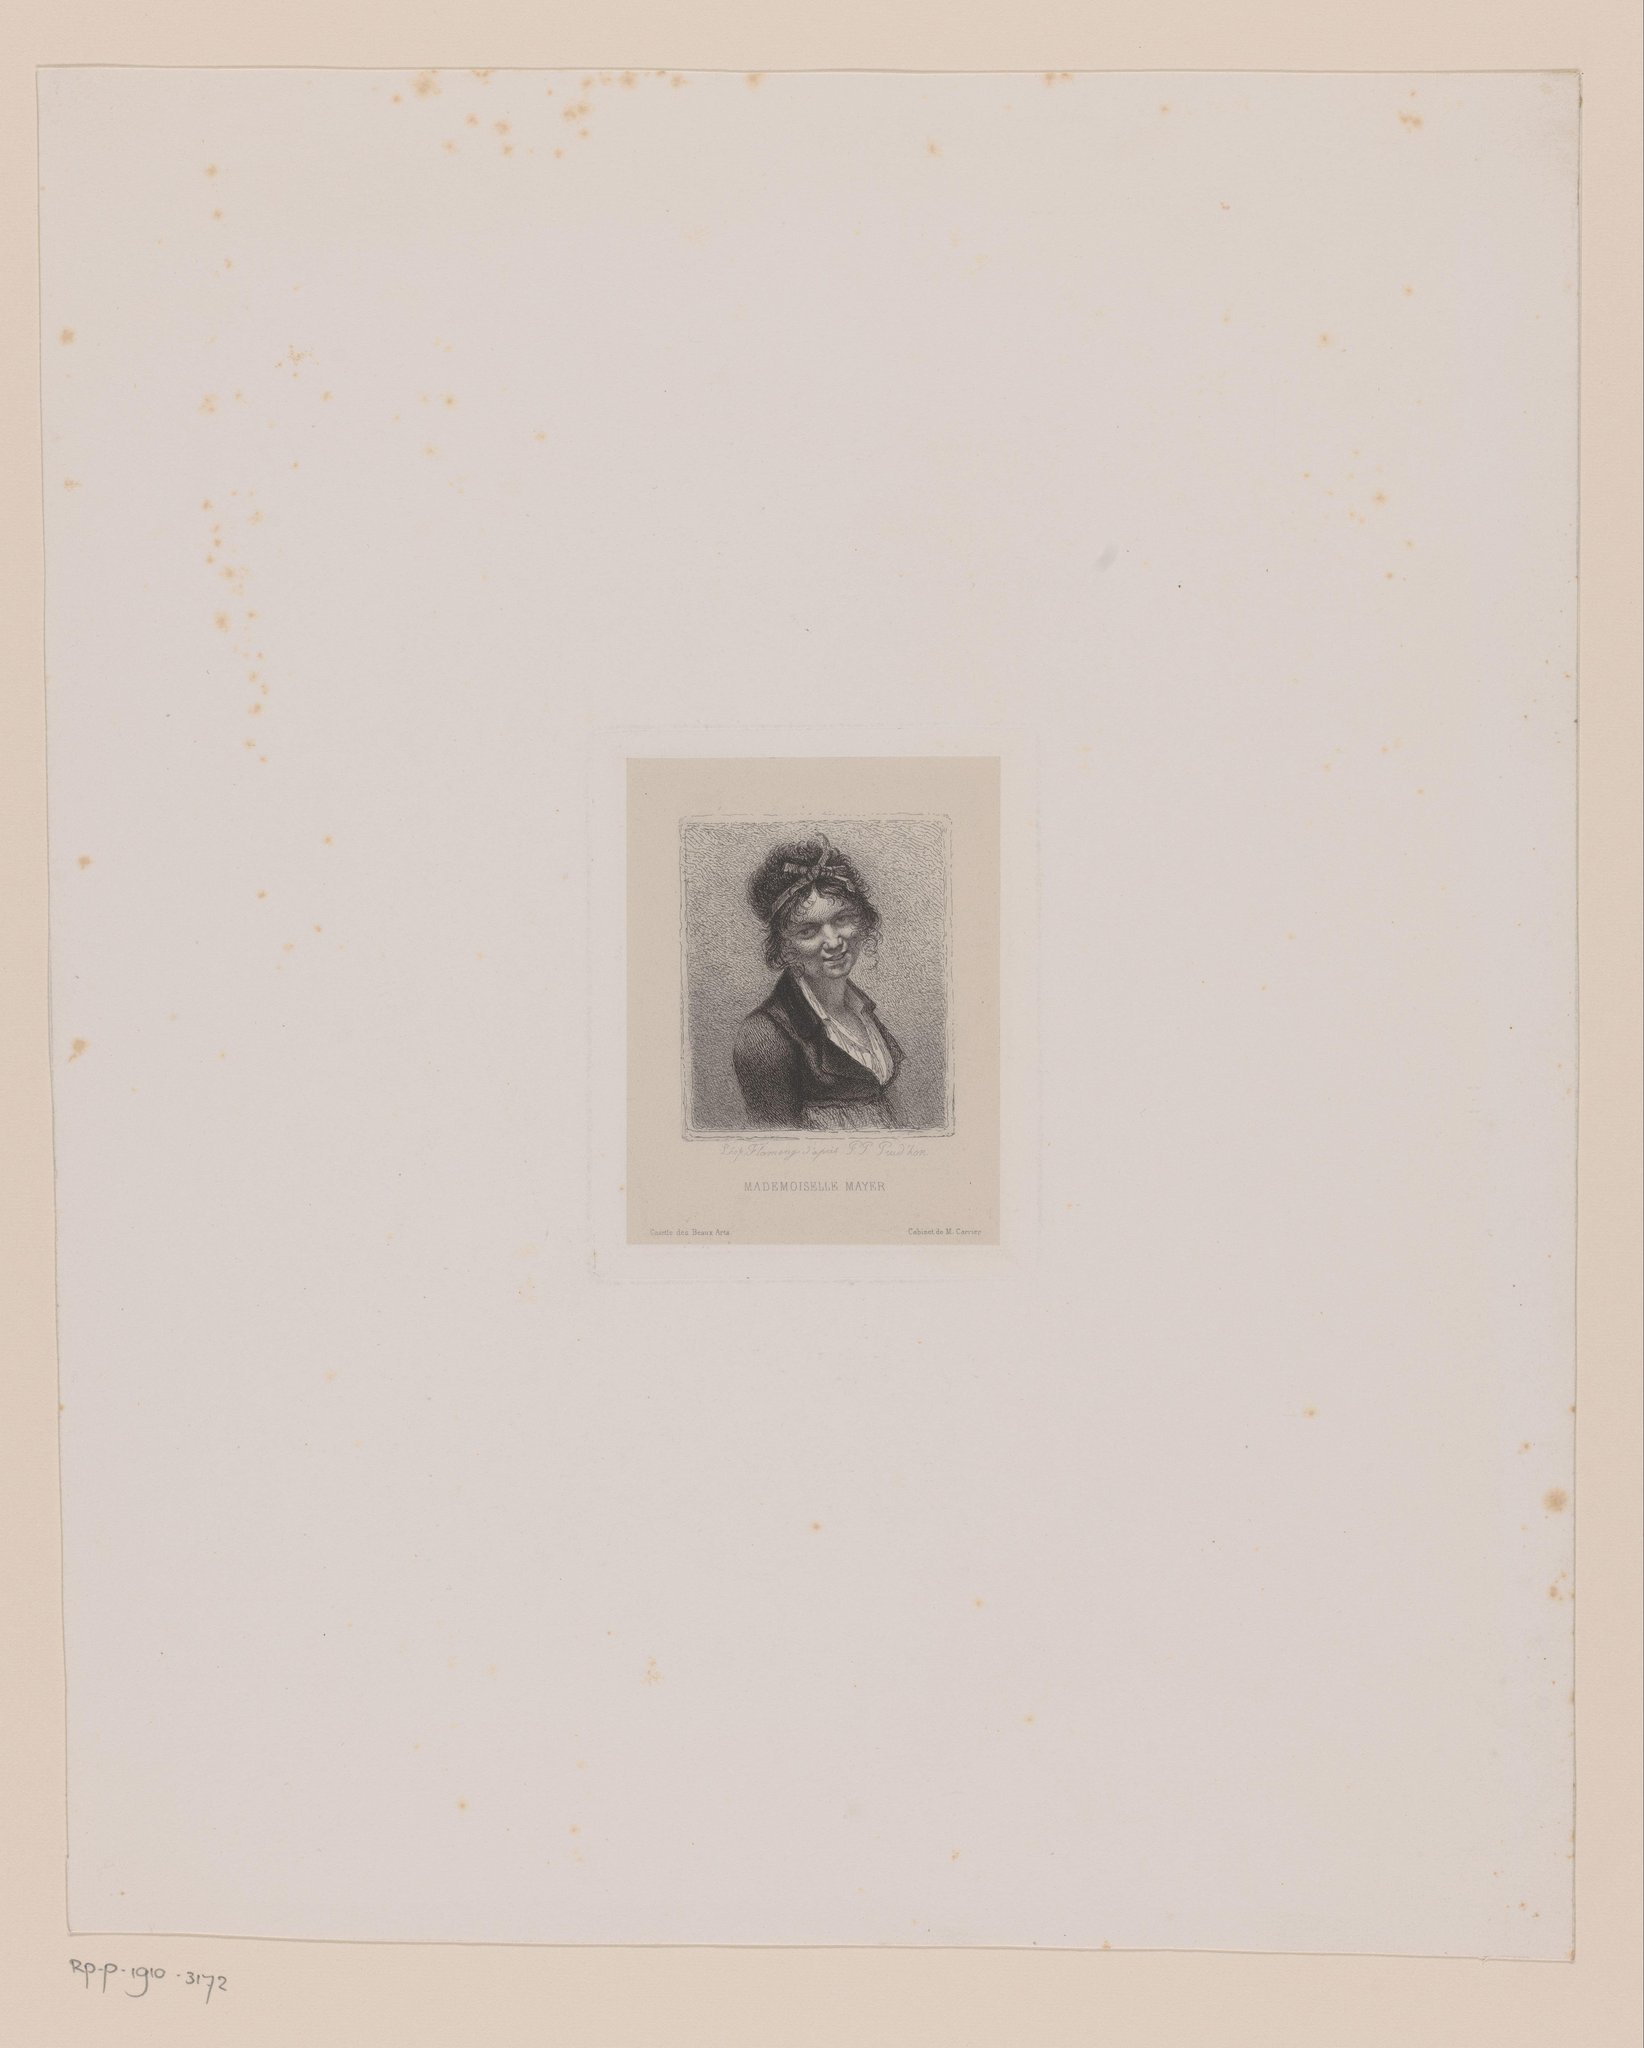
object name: print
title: Portret van een onbekende vrouw, mogelijk mevrouw Mayer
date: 1860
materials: paper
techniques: etching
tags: anonymous historical person portrayed alone - bb - woman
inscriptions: collector's mark: Lugt 2228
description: Prent uit: Gazette des beaux-arts (1860), dl. 3, p. 355.